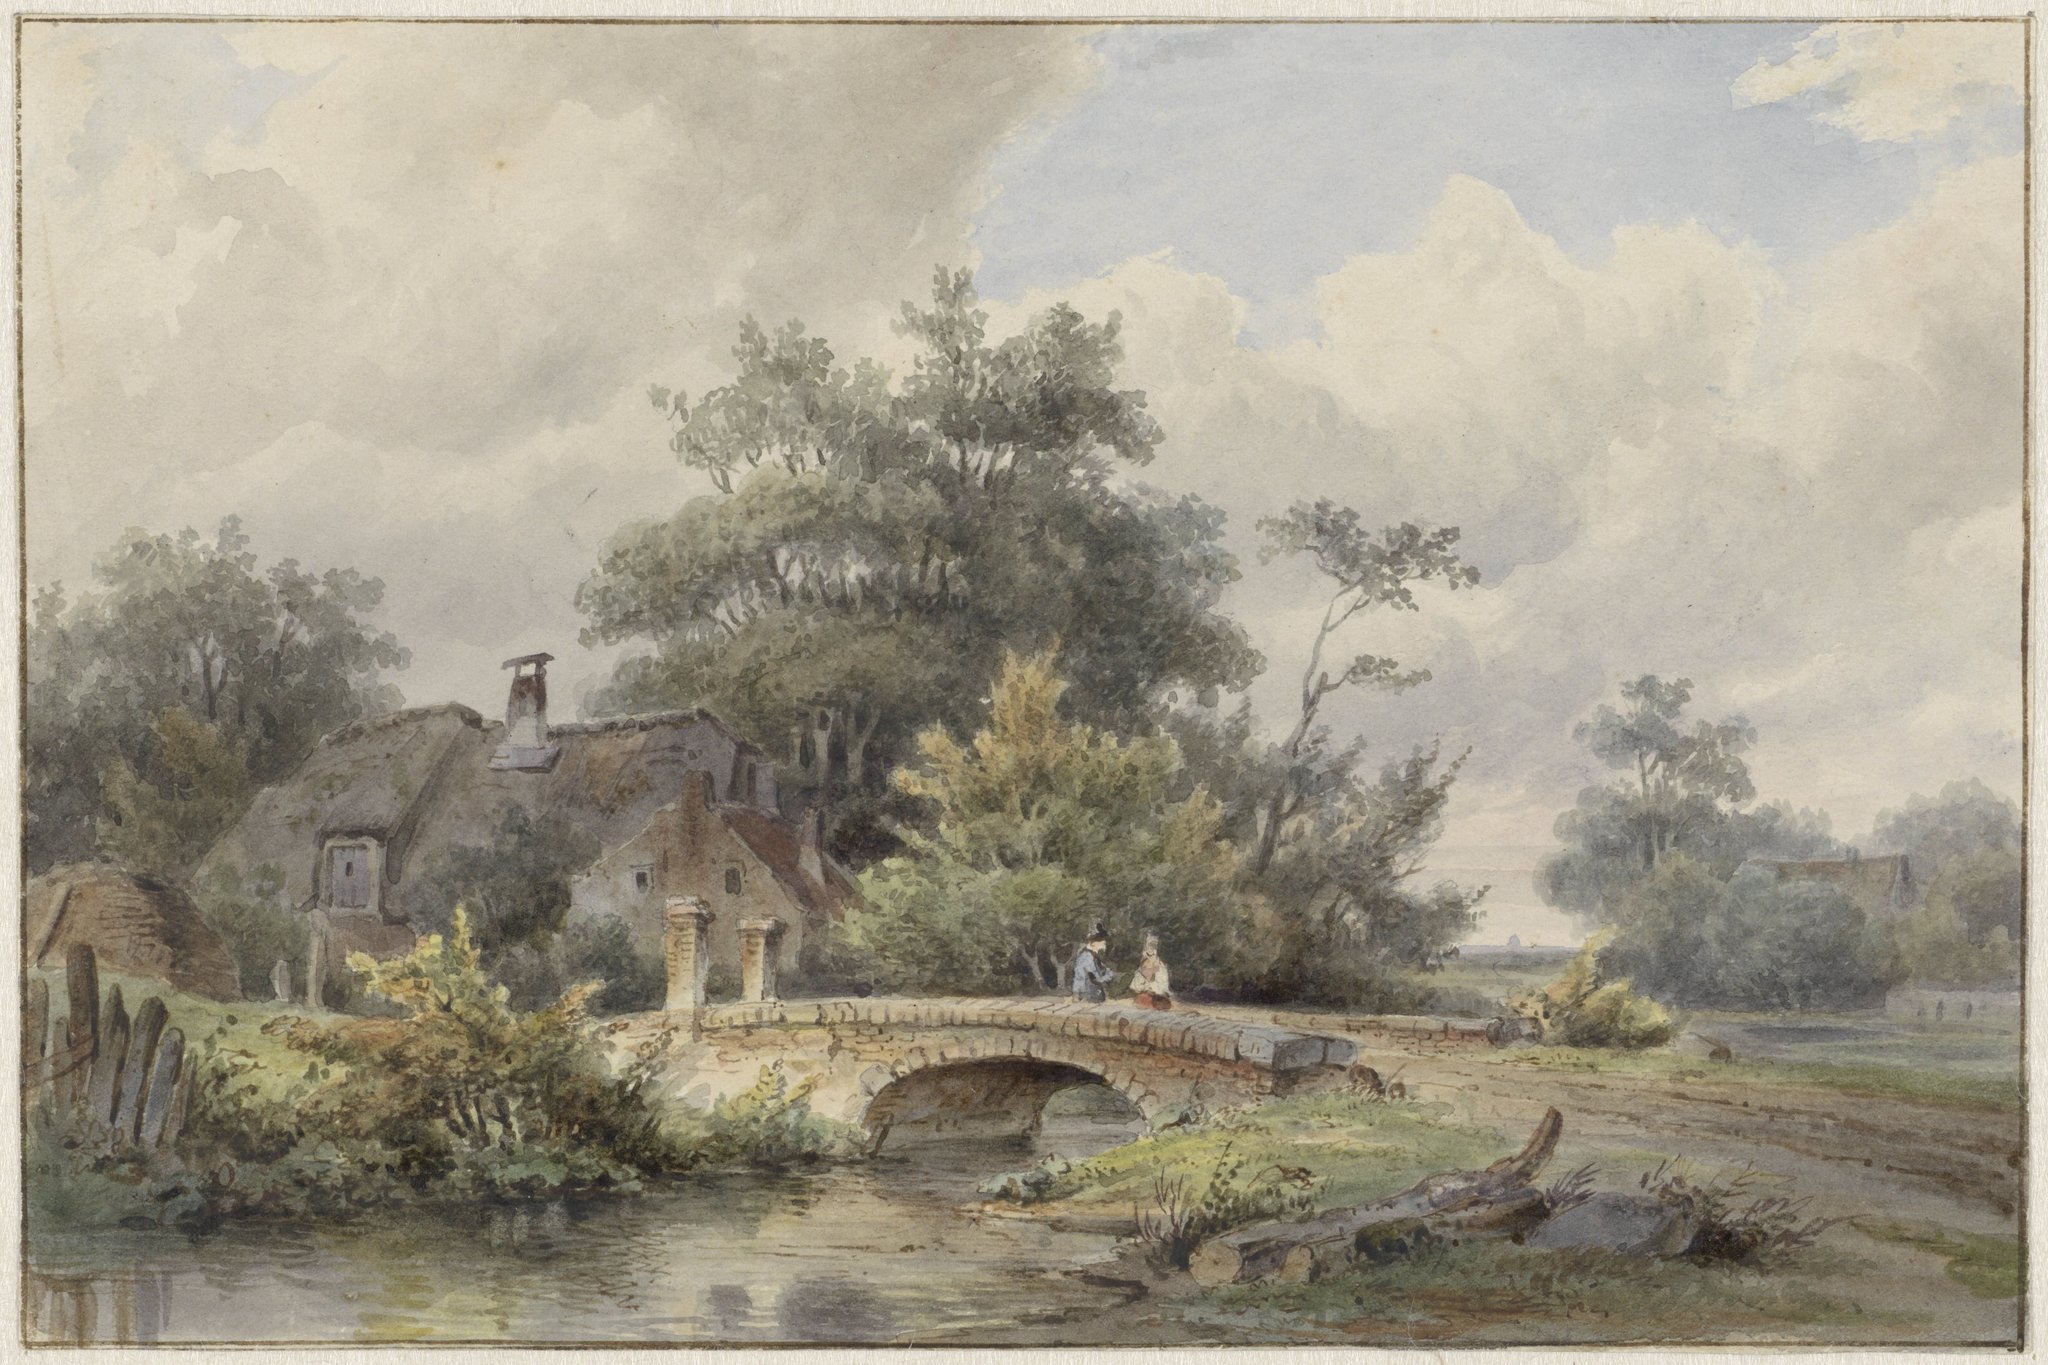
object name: watercolor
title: Landschap met stenen brug bij een huis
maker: barend cornelis koekkoek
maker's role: draughtsman, painter, print maker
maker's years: 1803-1862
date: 1813-1862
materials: ink, paper, watercolor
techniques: brush, pen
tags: farm or solitary house in landscape